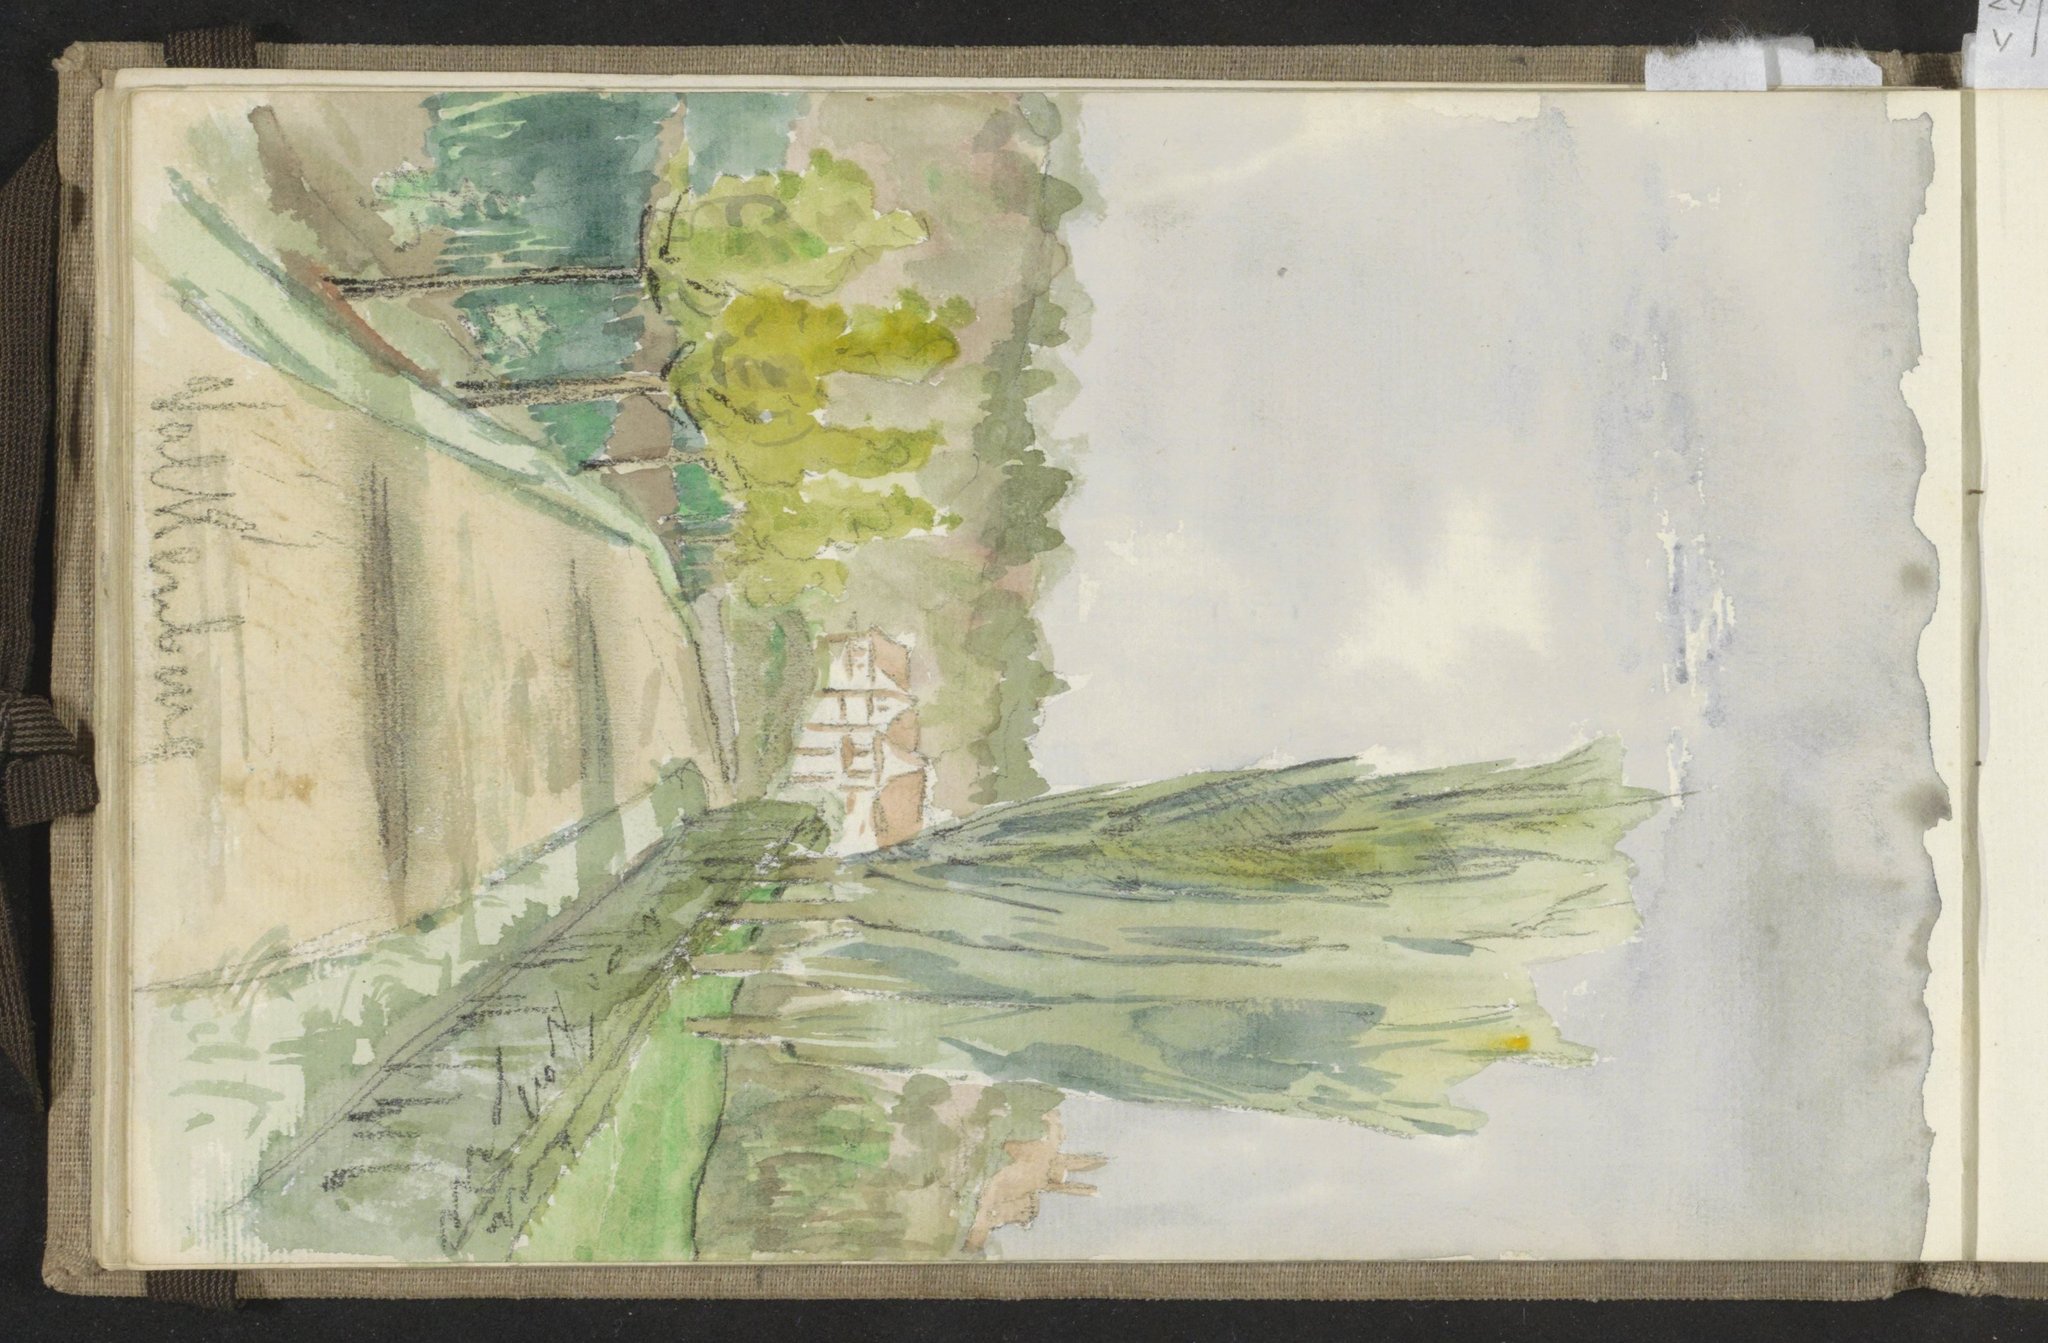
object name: sketchbook leaf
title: Weg naar Valkenburg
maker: jonkheer johannes ludovicus paulus bosch van drakestein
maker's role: draughtsman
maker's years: 1865-1929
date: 1896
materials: paper, pencil, watercolor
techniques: brush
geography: valkenburg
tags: prospect of village, silhouette of village, road, path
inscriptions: annotation: ‘Valkenburg’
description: Blad 23 verso uit een schetsboek met 58 bladen.